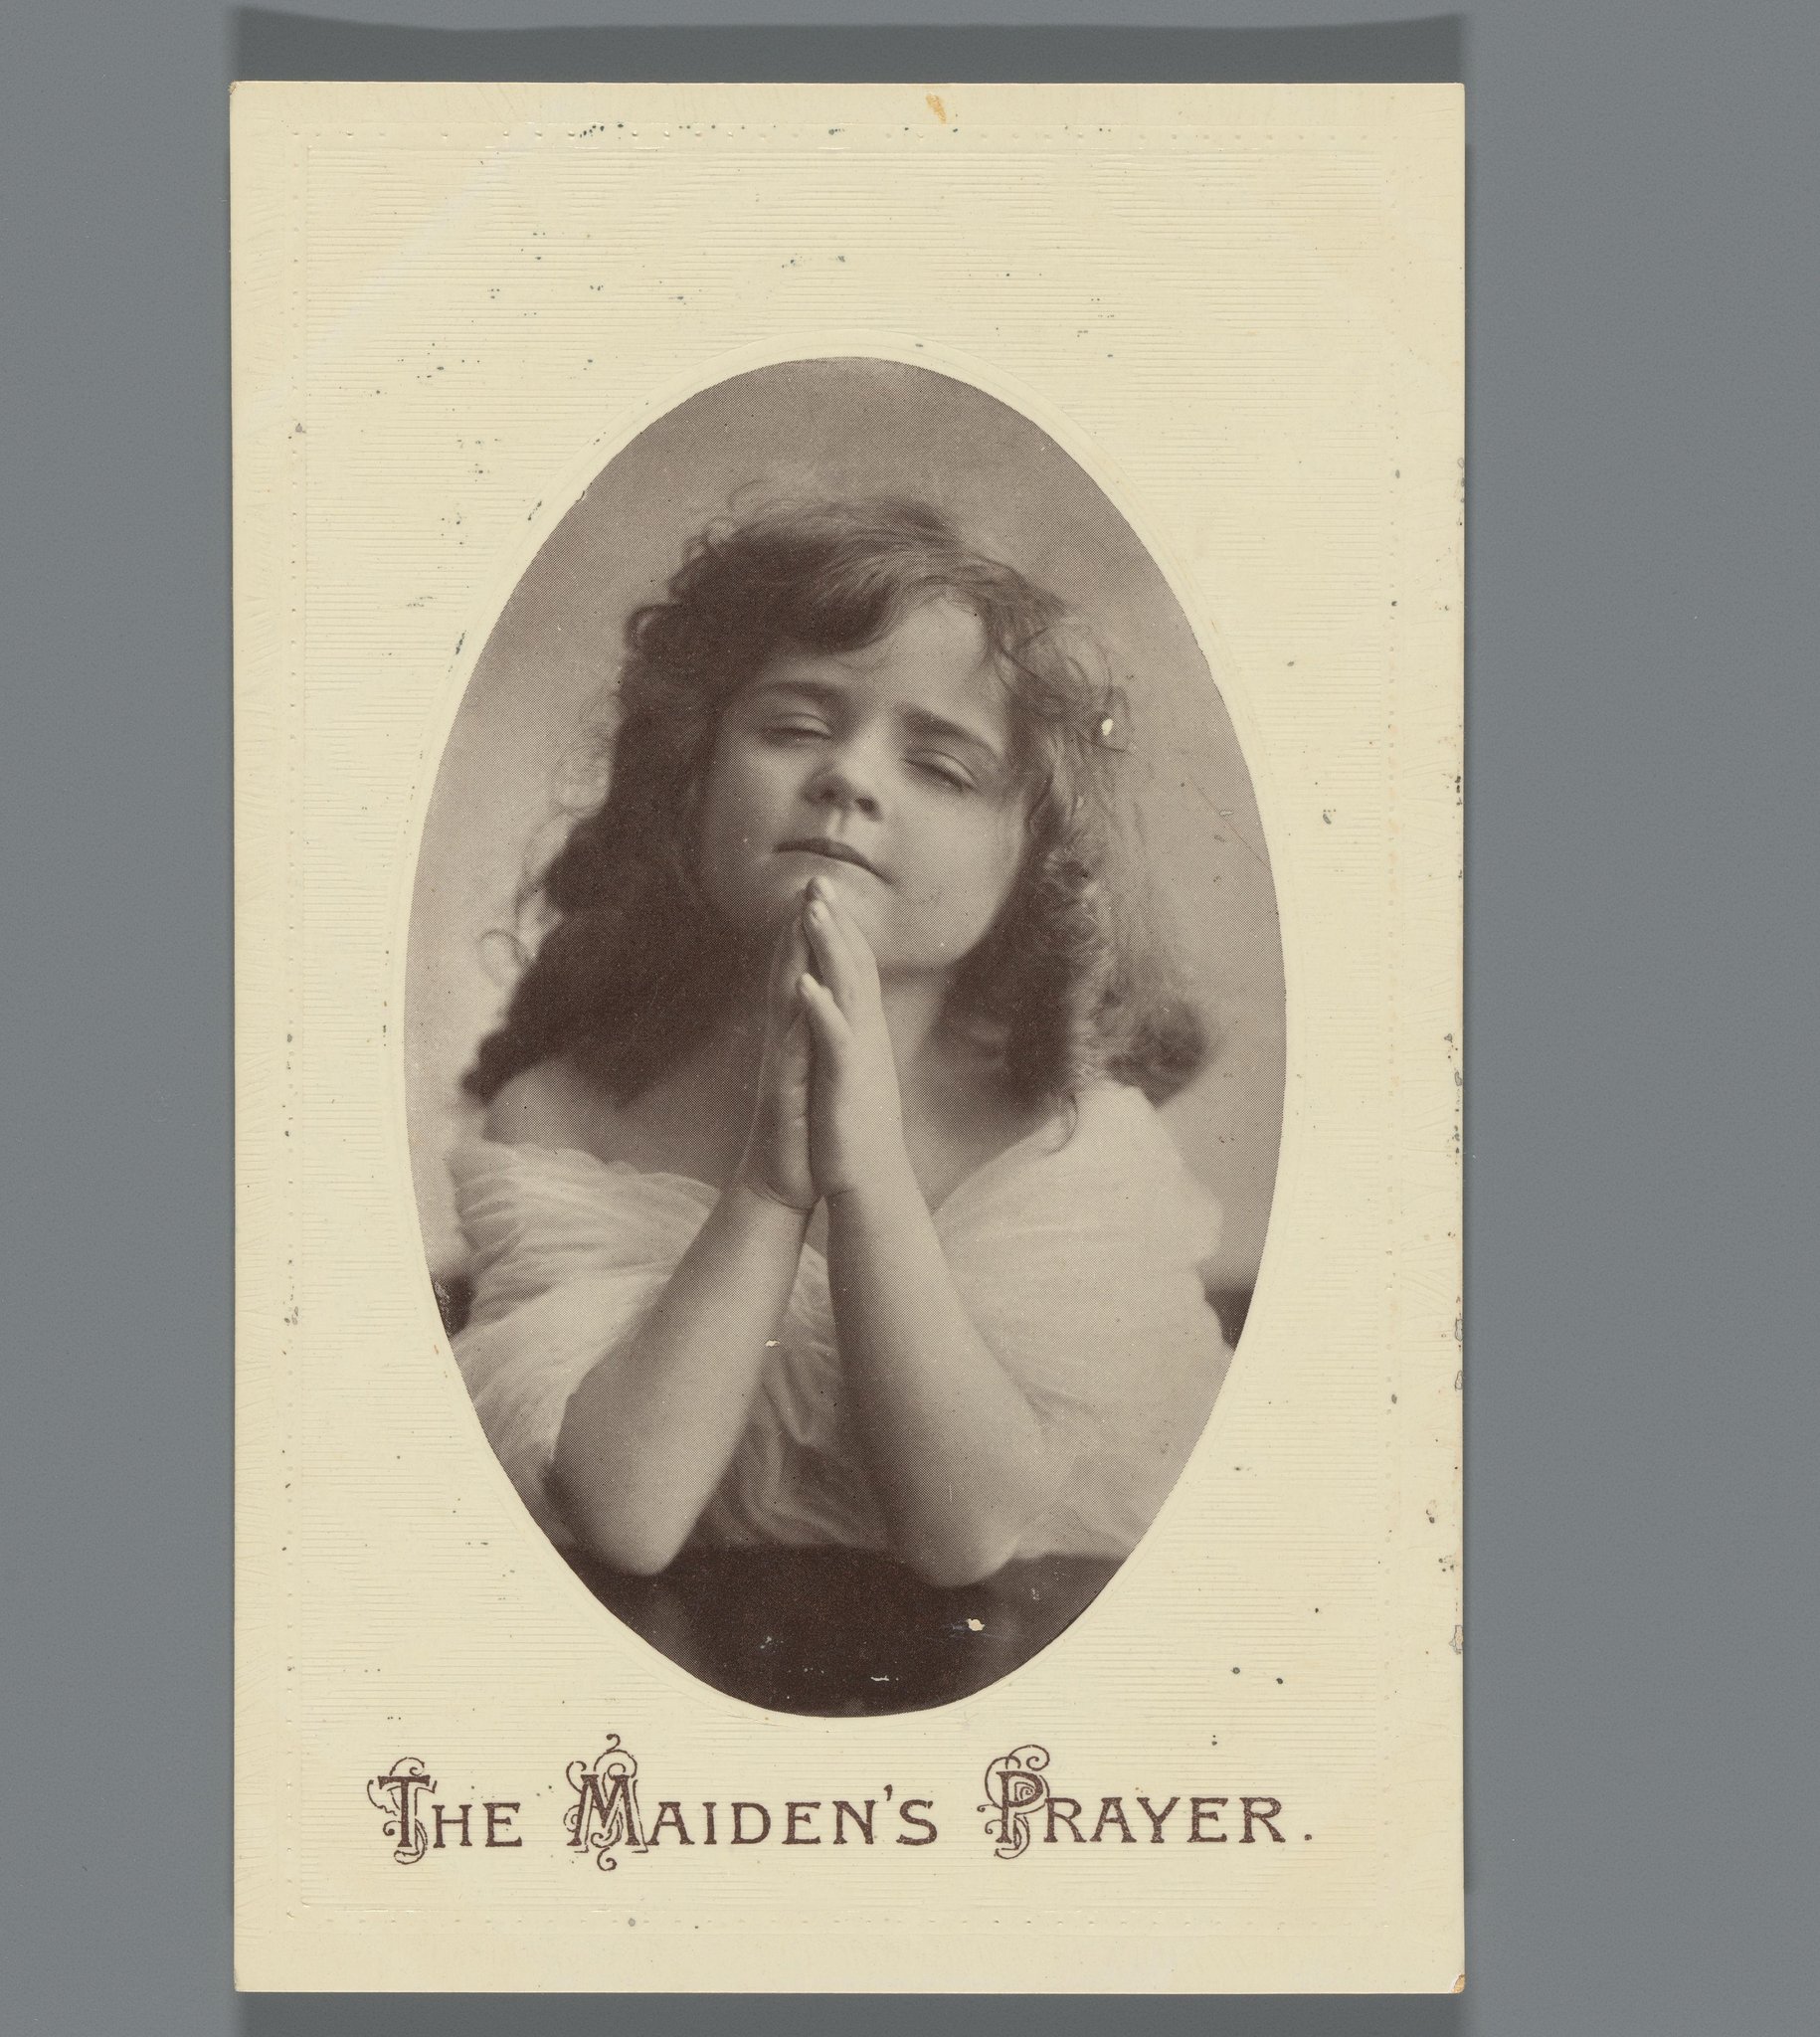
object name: photomechanical print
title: The maiden's prayer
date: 1906-1909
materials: paper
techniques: autotype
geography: london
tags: child, one person praying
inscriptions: inscription: ‘No. 78. Printed in Saxony.’